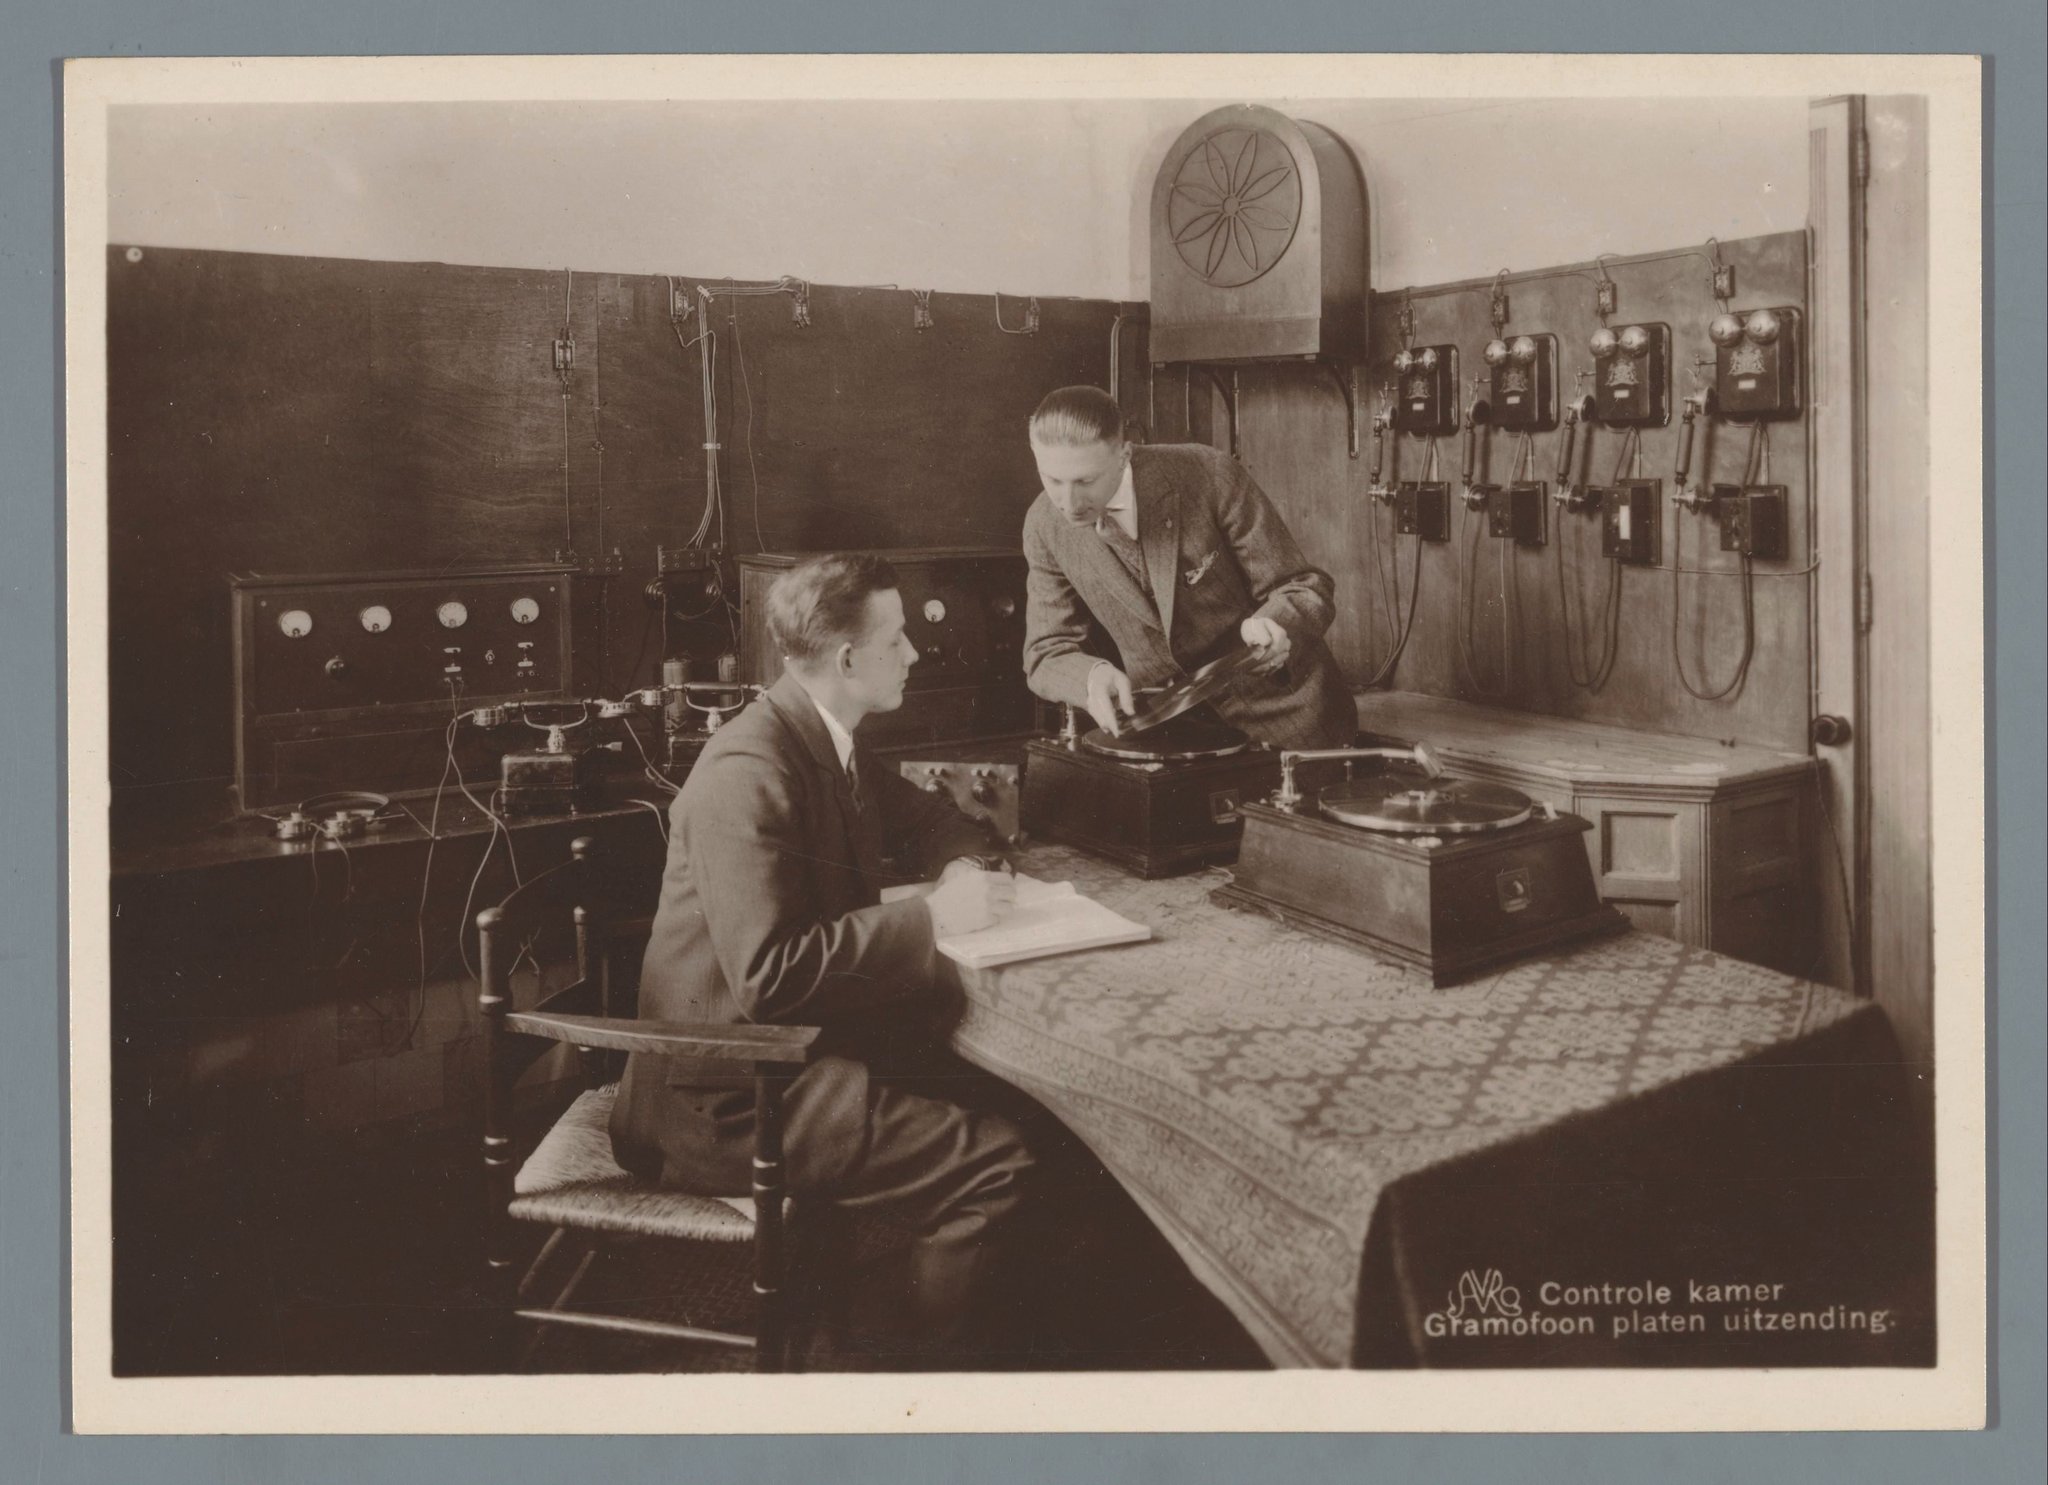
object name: photograph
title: A.V.R.O. Controle kamer/ Gramofoon platen uitzending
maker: Anonymous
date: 1928-1945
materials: paper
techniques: gelatin silver print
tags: phonograph, gramophone; playing recorded sound or video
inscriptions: number: ‘10’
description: Deze foto maakt deel uit van een omslag met tien foto's.